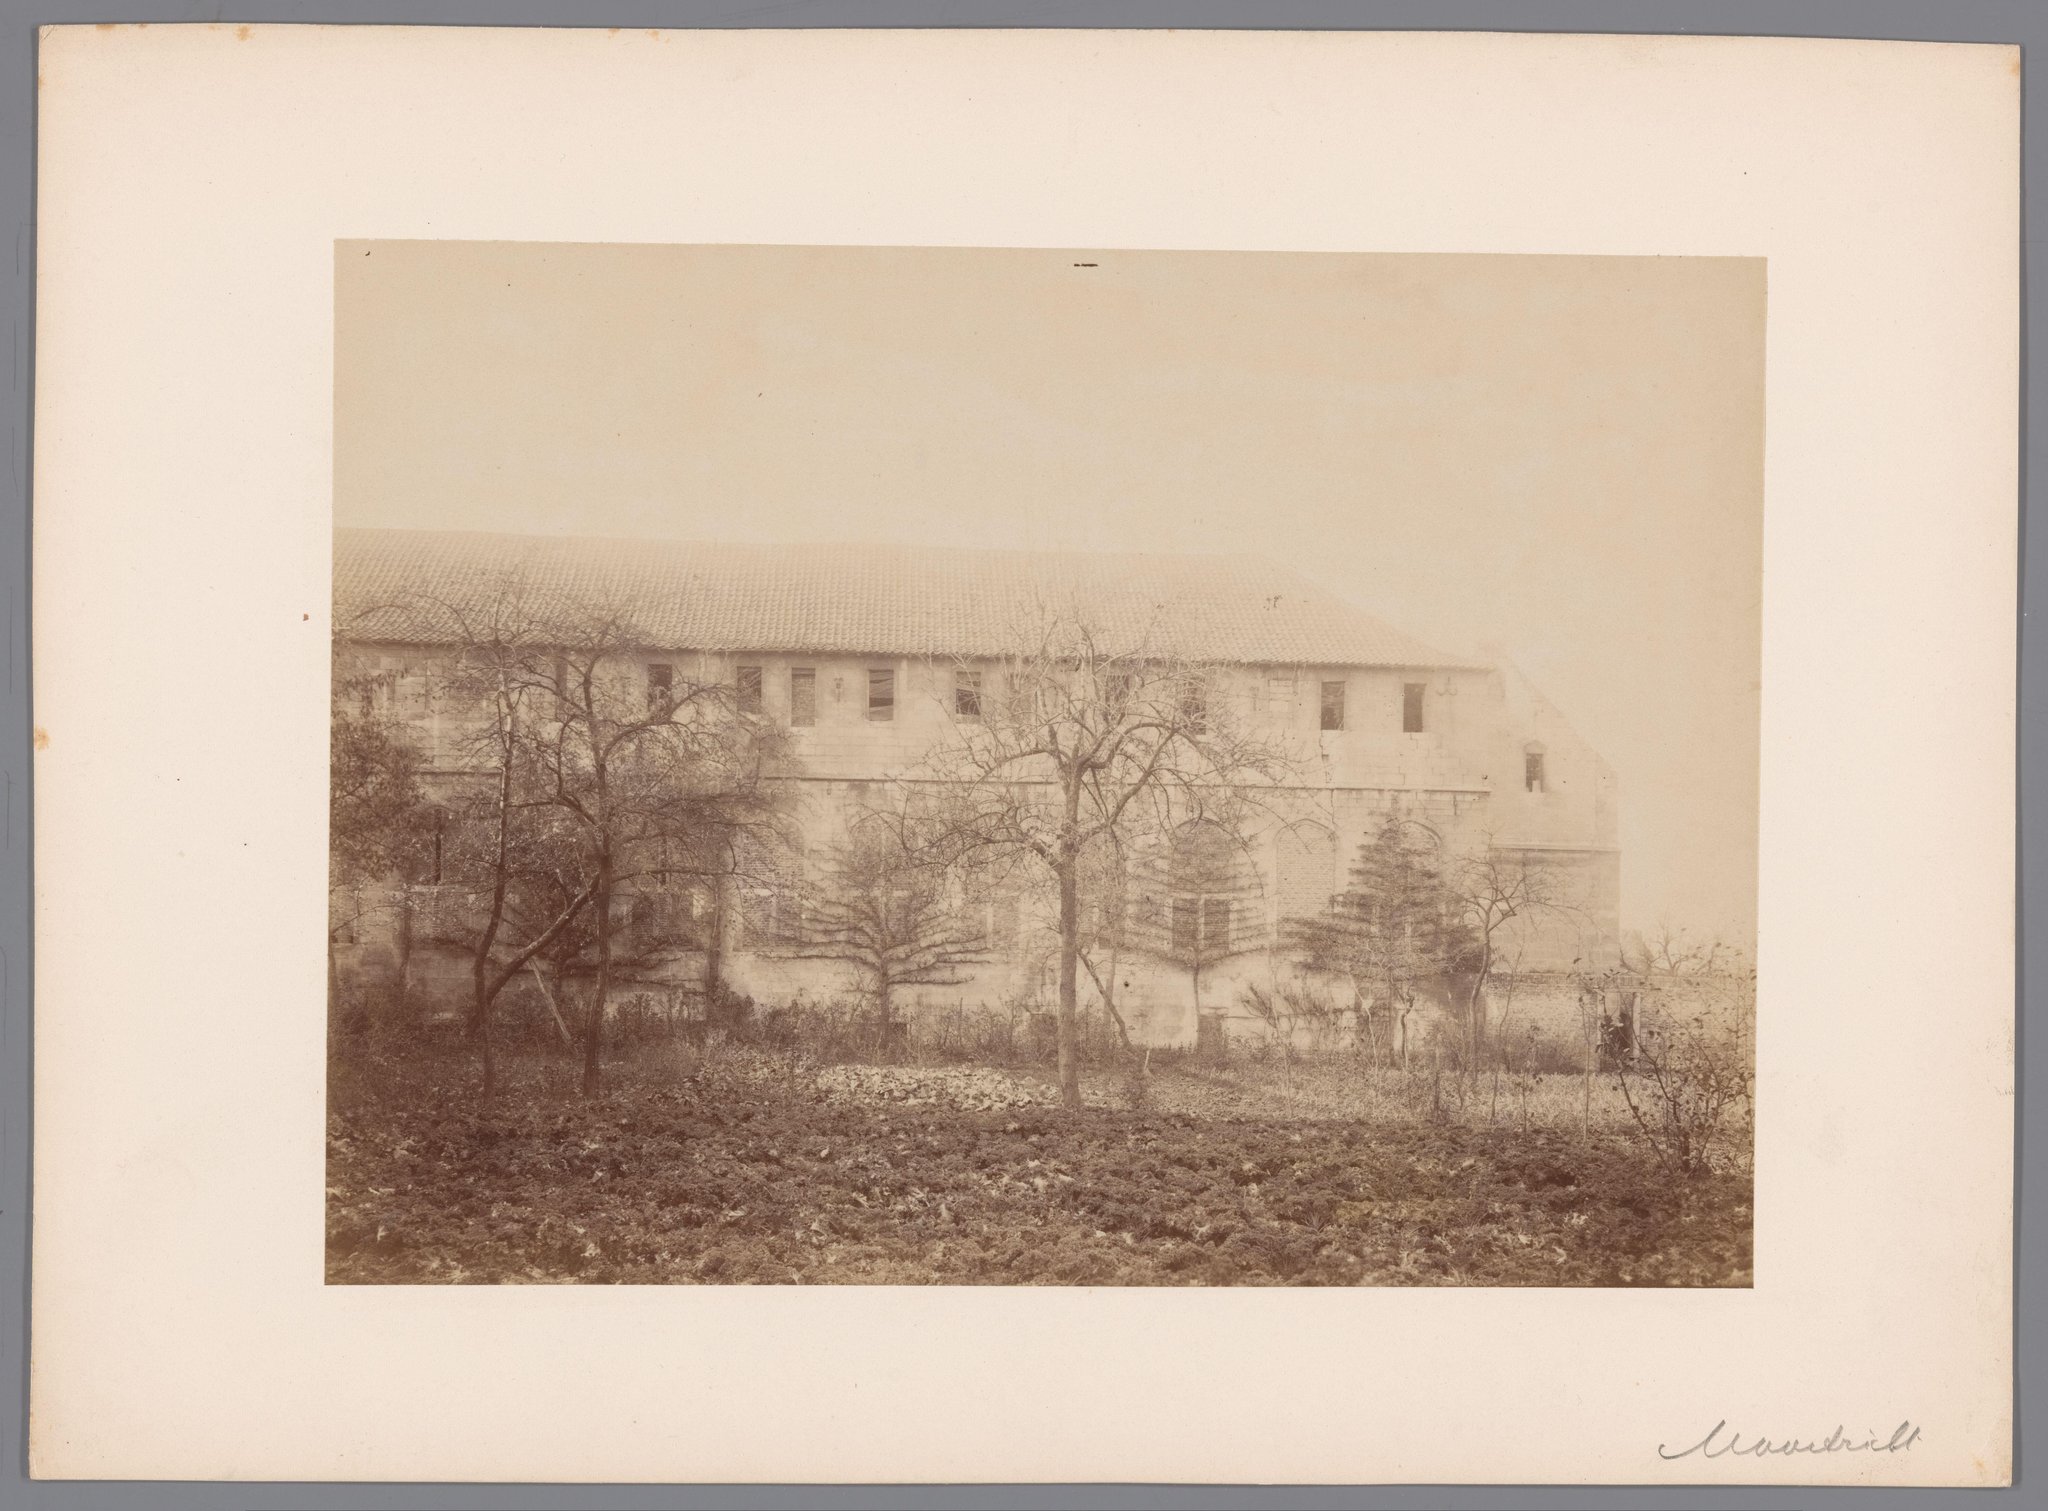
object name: photograph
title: Gedeelte van het oude Beyart klooster te Maastricht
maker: anoniem (monumentenzorg)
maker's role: fotograaf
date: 1893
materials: cardboard, photographic support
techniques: albumen print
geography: maastricht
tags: ruin of church, monastery, etc.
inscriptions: annotation: ‘Maastricht (L.)/ Beyaertgebouwen/ geizen vanaf punt f./ Nov 1893’, annotation: ‘Maastricht’